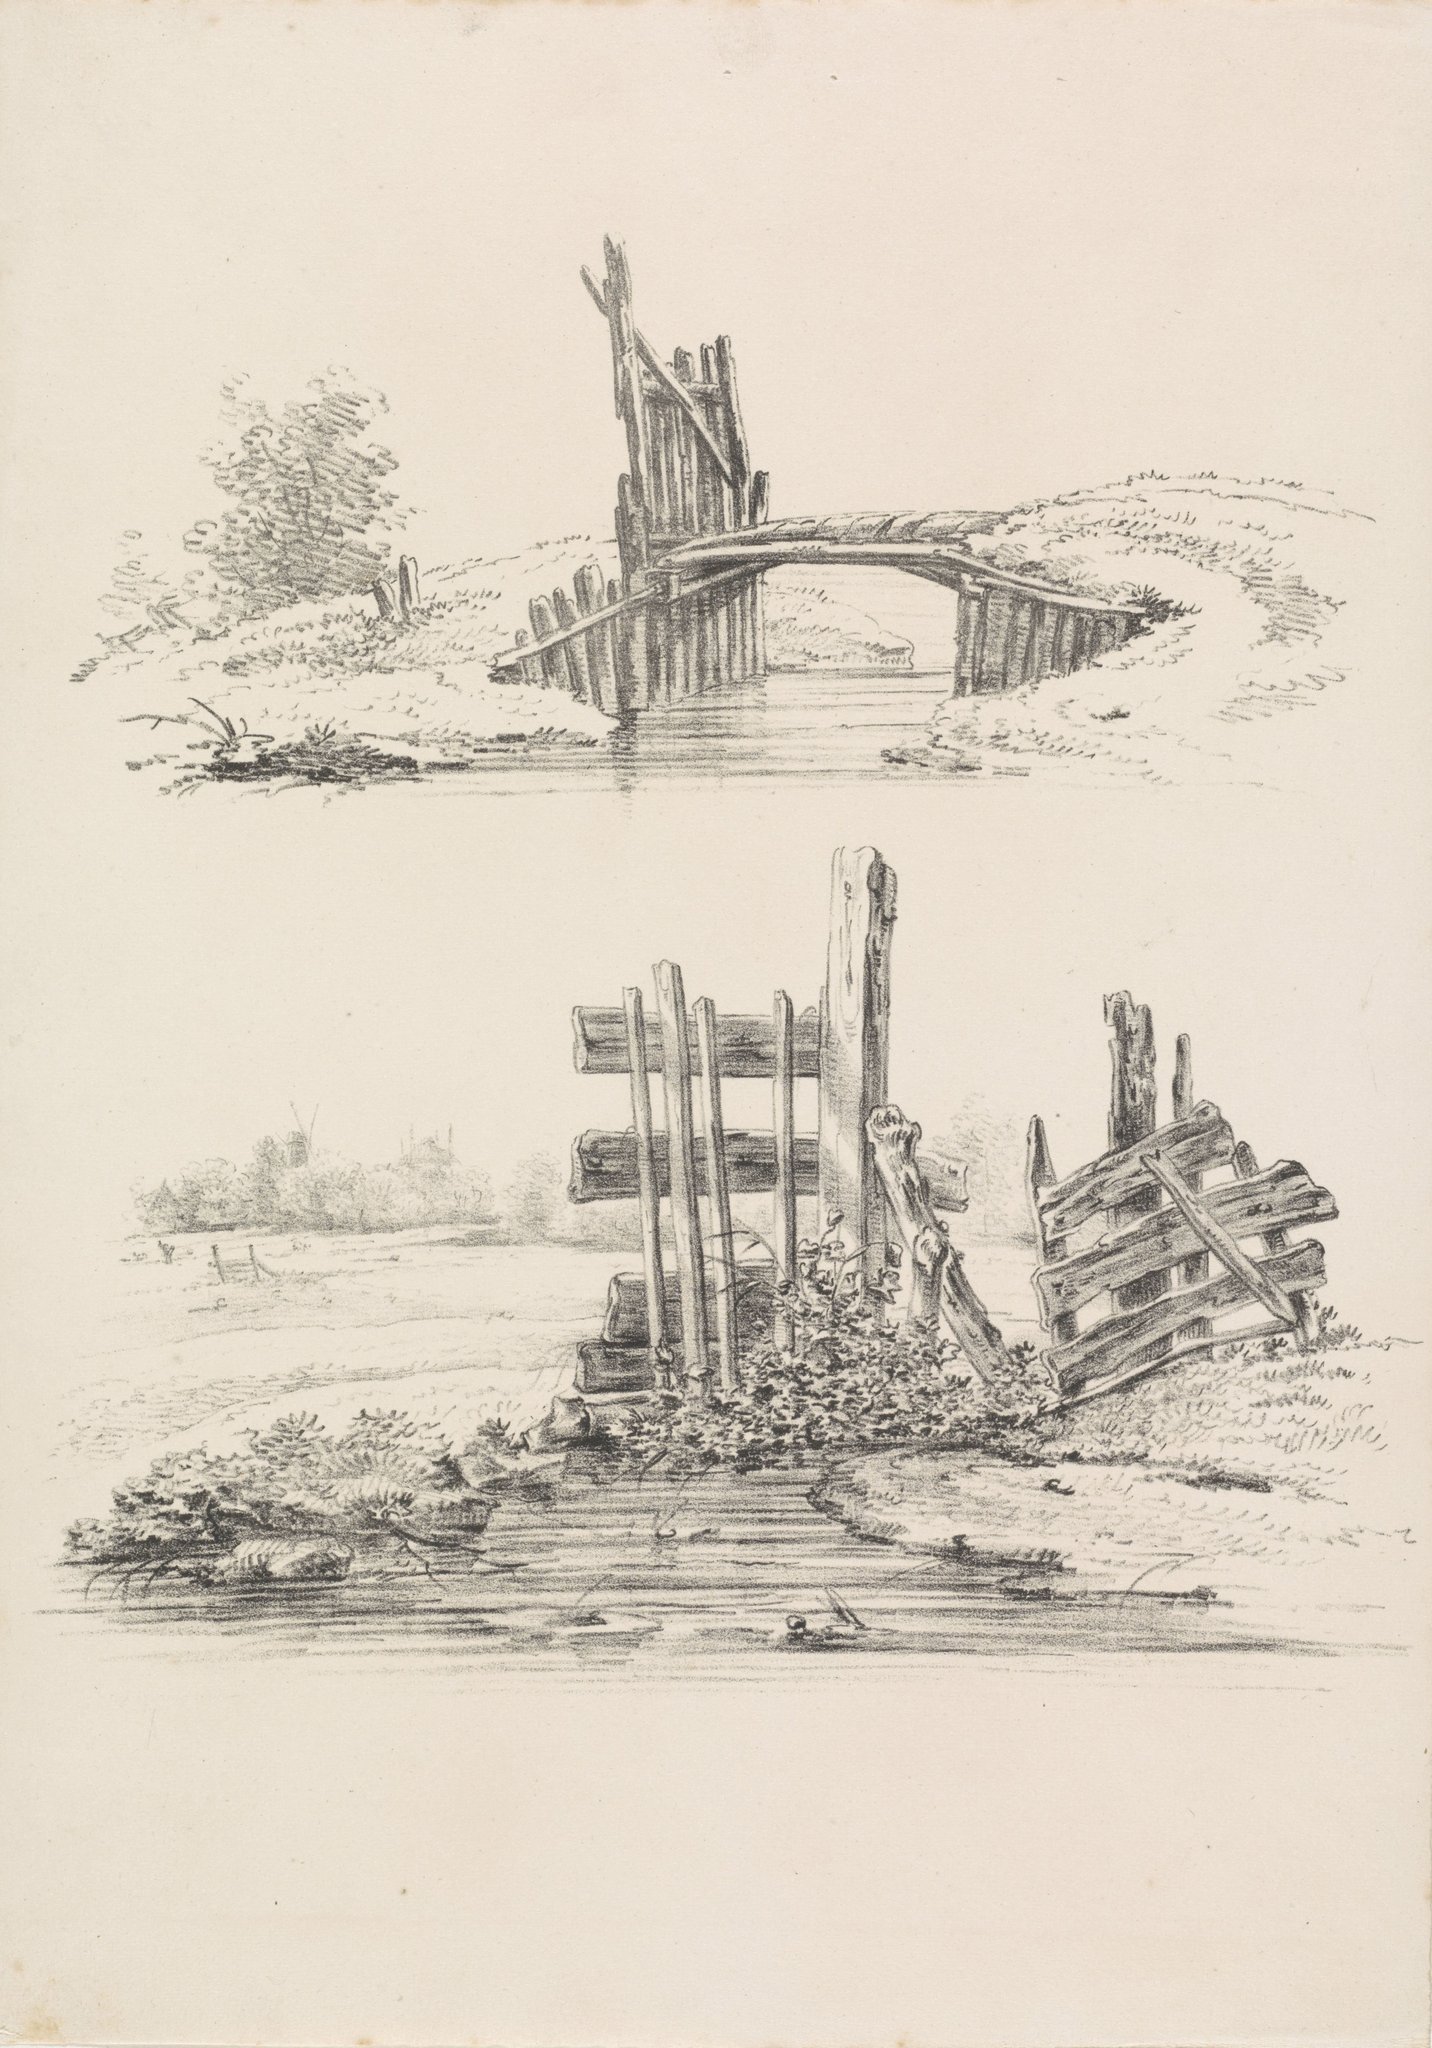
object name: print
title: Twee voorstellingen van een hek en een brug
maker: joannes bemme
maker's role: print maker, printer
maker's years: 1775-1841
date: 1809-1841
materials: paper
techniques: lithograph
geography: netherlands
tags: fence, wall, paling, windmill in landscape, small canal, ditch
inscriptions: collector's mark: Lugt 2228, watermark: ‘C&II’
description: Voor de brug over de sloot staat een houten hek. Het hek in de onderste voorstelling is vervallen en begroeid met planten. In de achtergrond een molen en wat huizen.